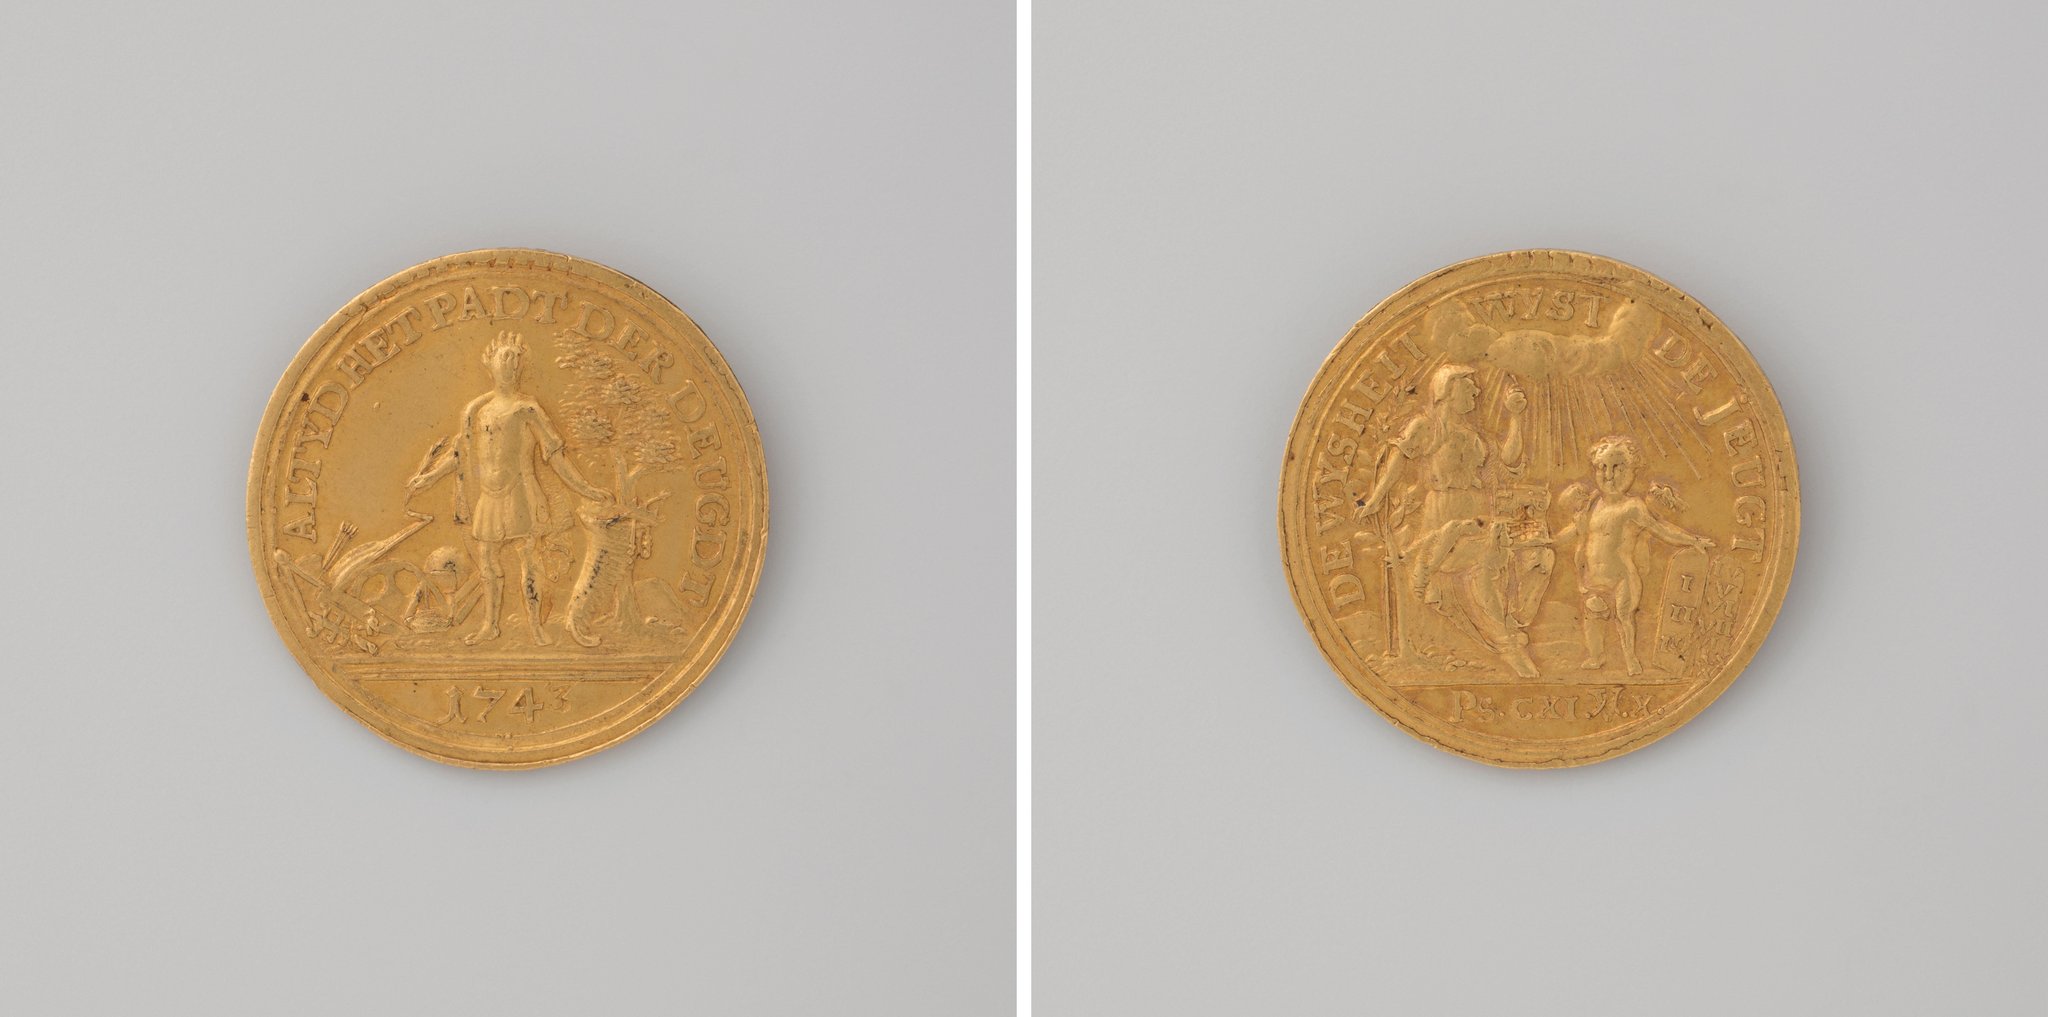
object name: medal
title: Prijspenning der scholen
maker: Anonymous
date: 1743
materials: gold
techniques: engraving, striking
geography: netherlands